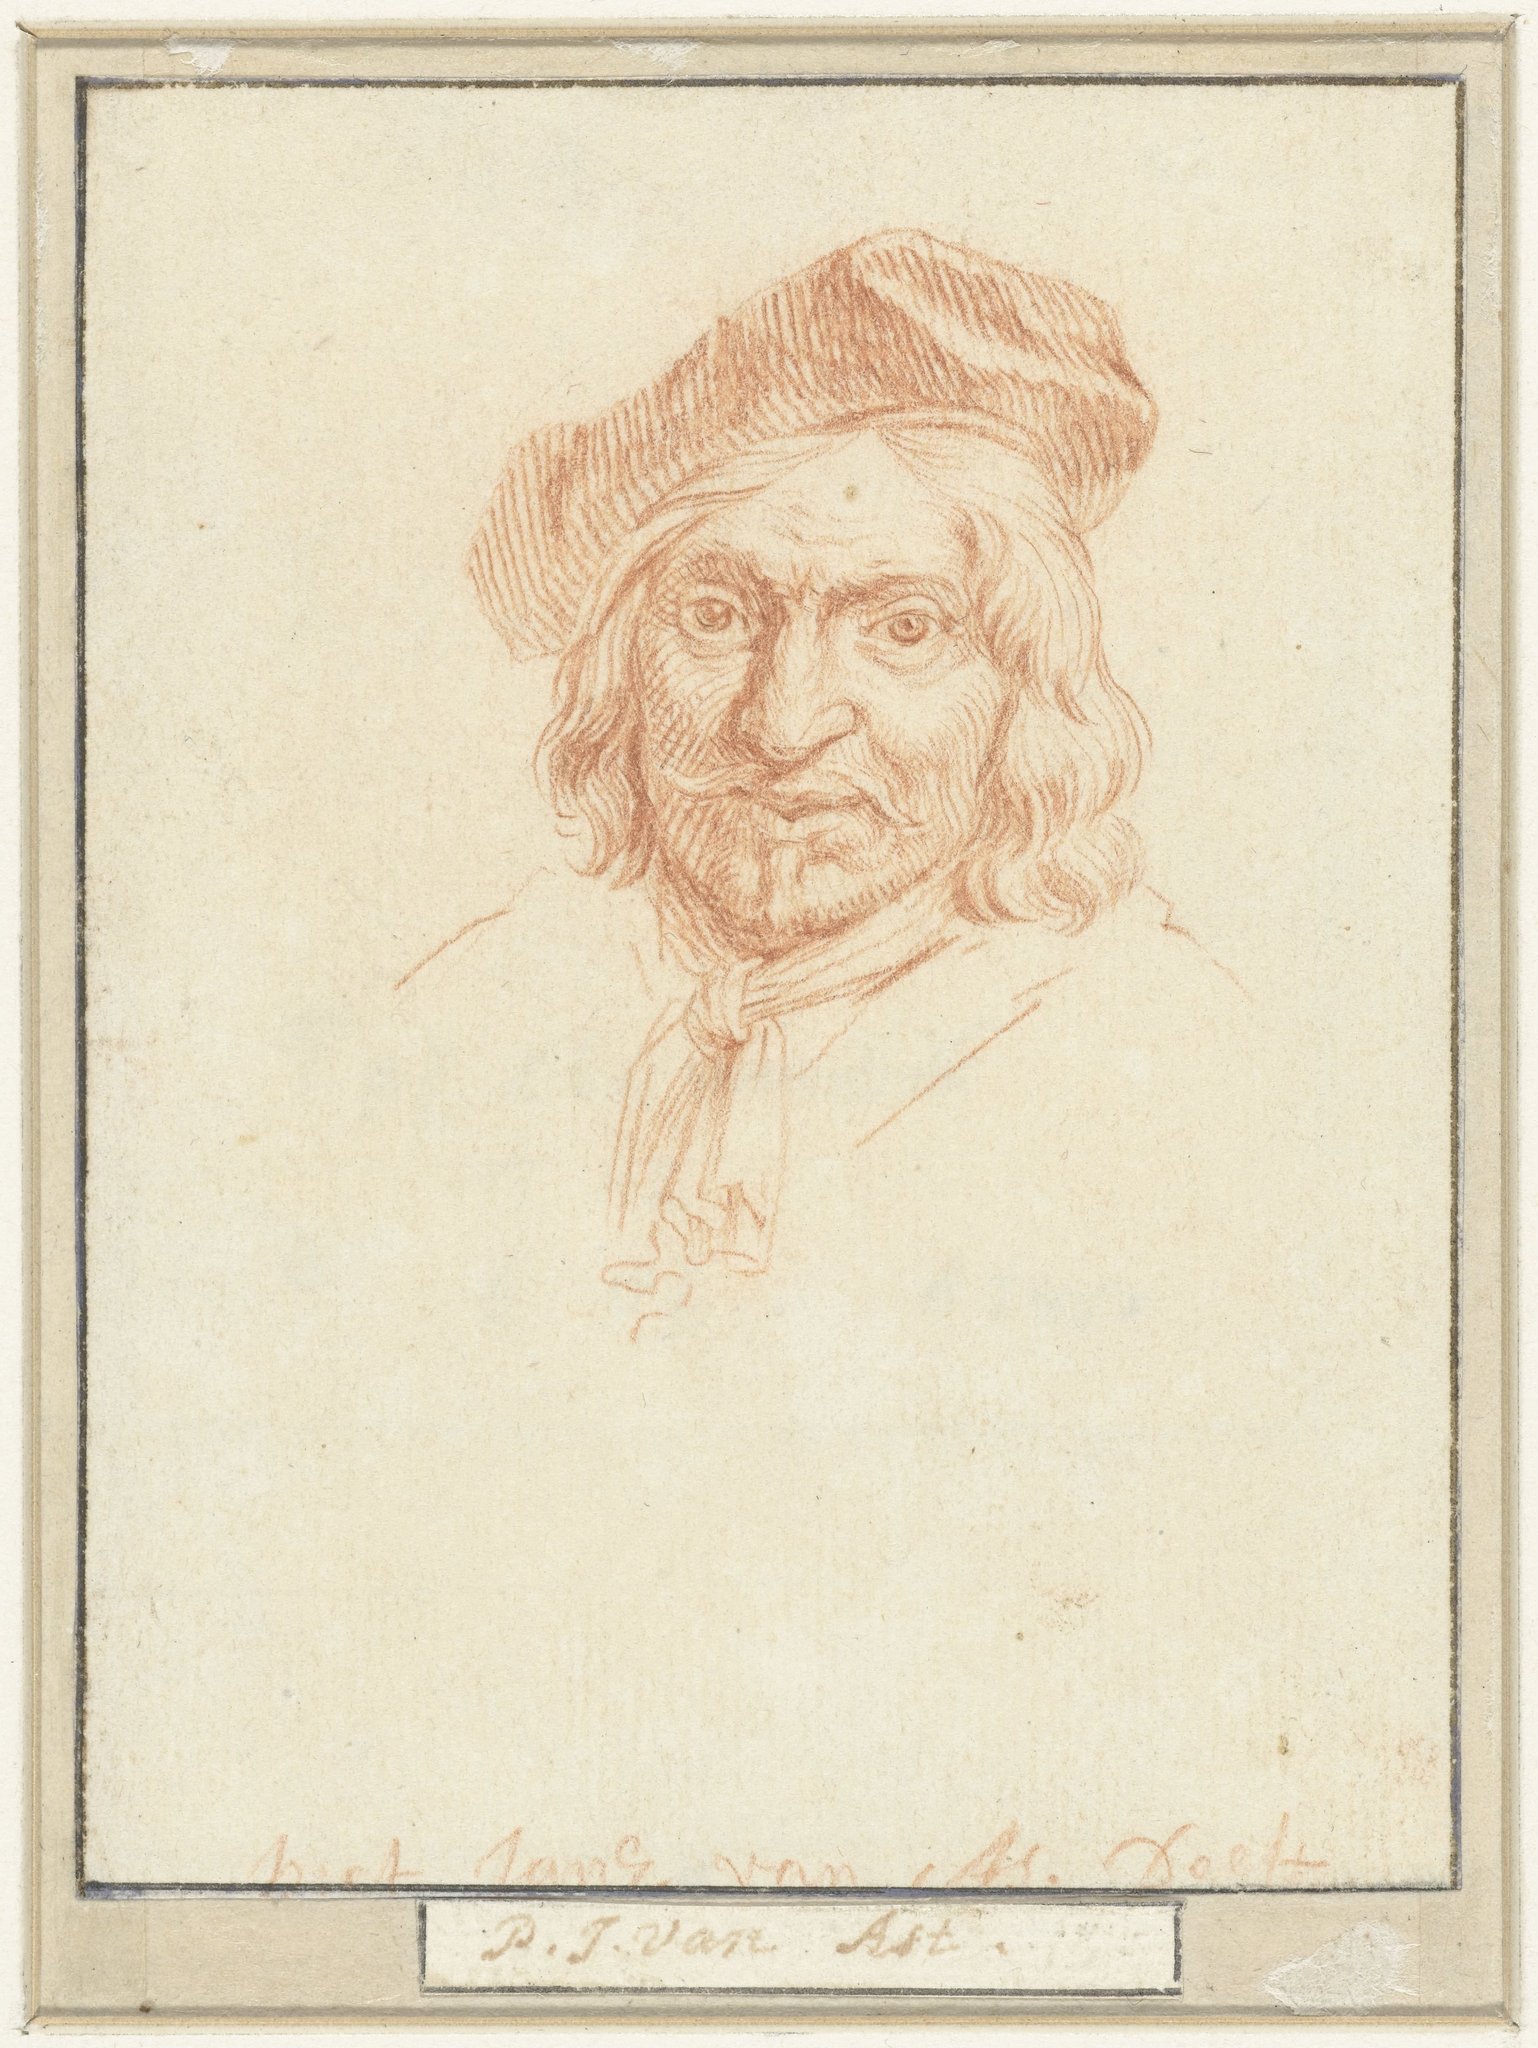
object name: design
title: Portret van Pieter Jansz. van Asch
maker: jacob houbraken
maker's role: draughtsman, print maker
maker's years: 1698-1780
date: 1708-1780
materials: chalk, paper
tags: painter, draughtsman, pieter jansz van asch, historical persons, portrait, self-portrait of painter, portrait, self-portrait of artist